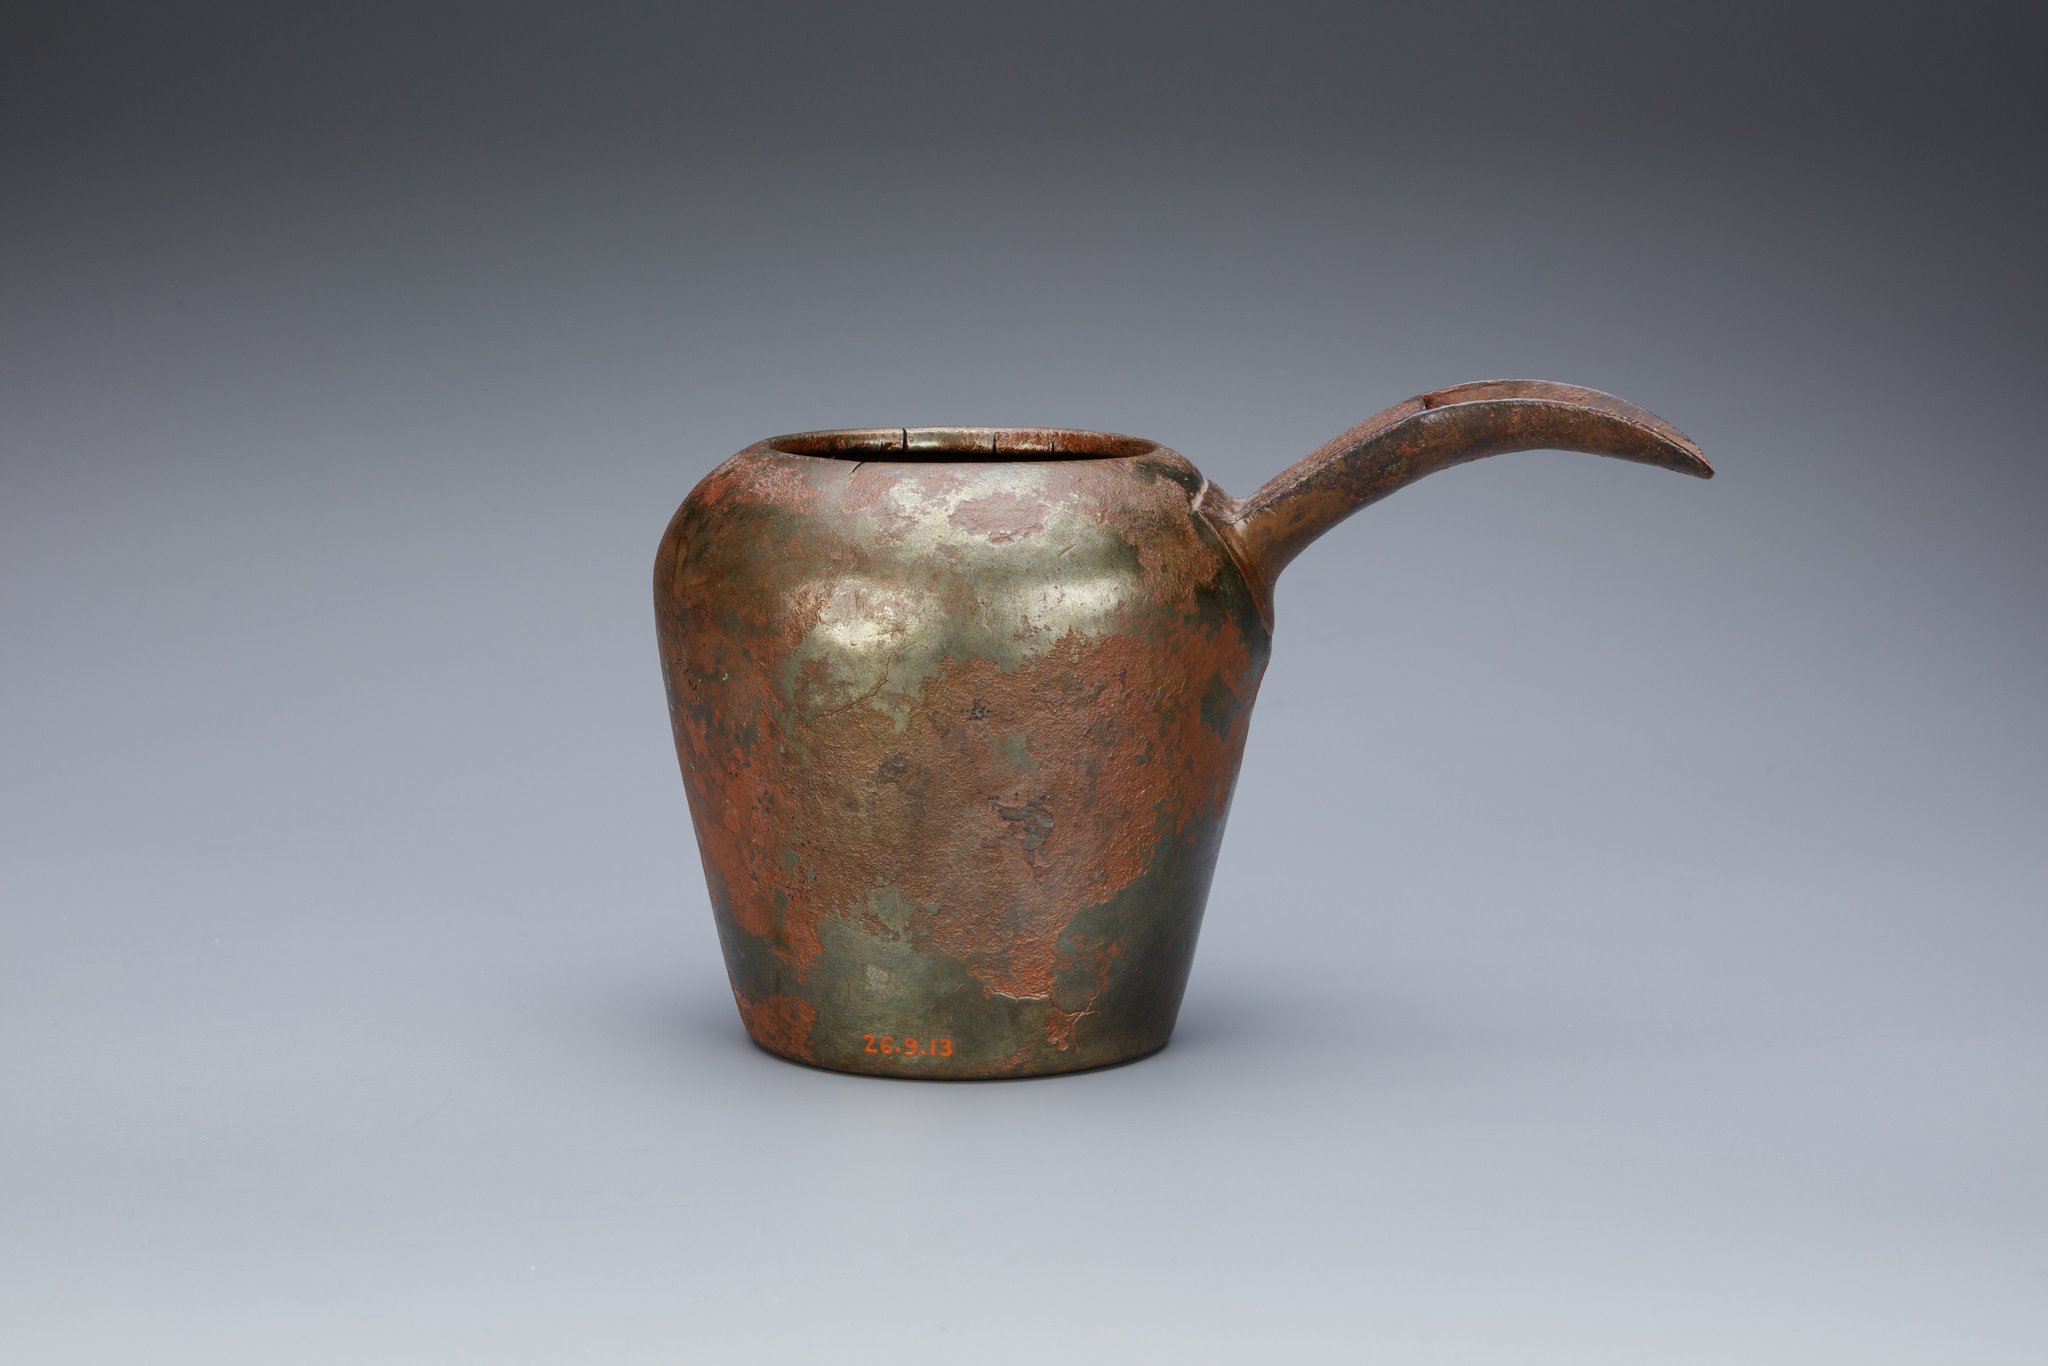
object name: ewer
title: Ewer, from basin and ewer set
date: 2465-2323 BCE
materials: copper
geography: egypt